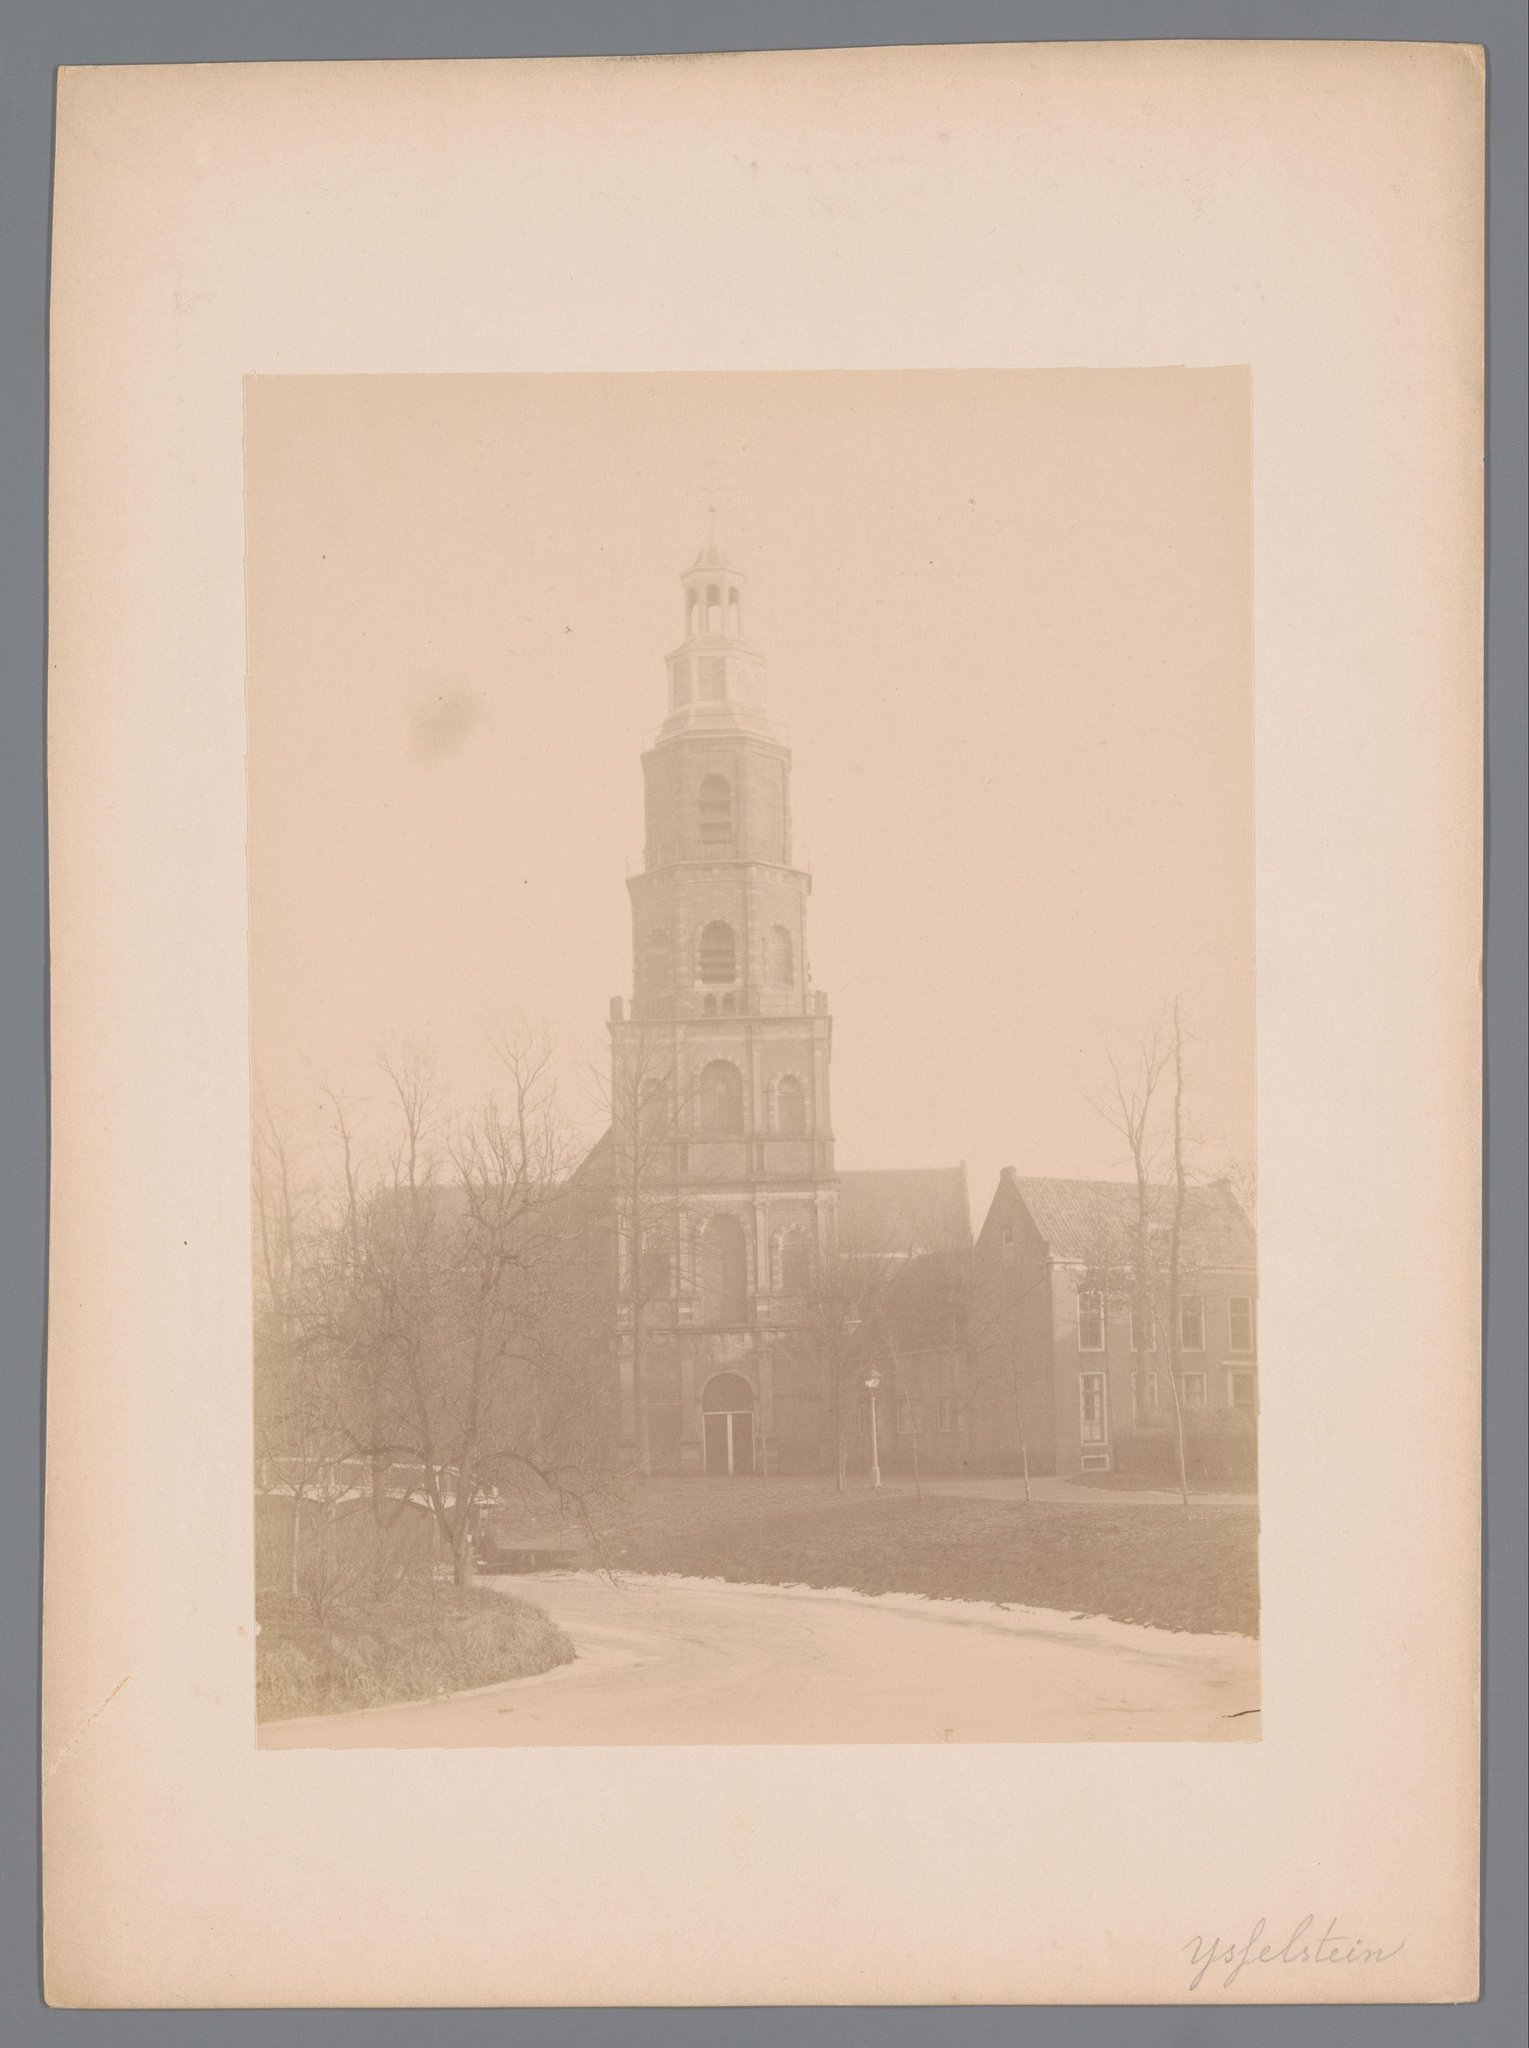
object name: photograph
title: Gezicht op de Oude Sint-Nicolaaskerk te IJsselstein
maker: anoniem (monumentenzorg)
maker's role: fotograaf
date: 1880-1910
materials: cardboard, photographic support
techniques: albumen print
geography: ijsselstein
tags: church (exterior)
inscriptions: annotation: ‘IJsselstein’, annotation: ‘Toren v/d Ned. Herv. gemeente te IJsselstein’